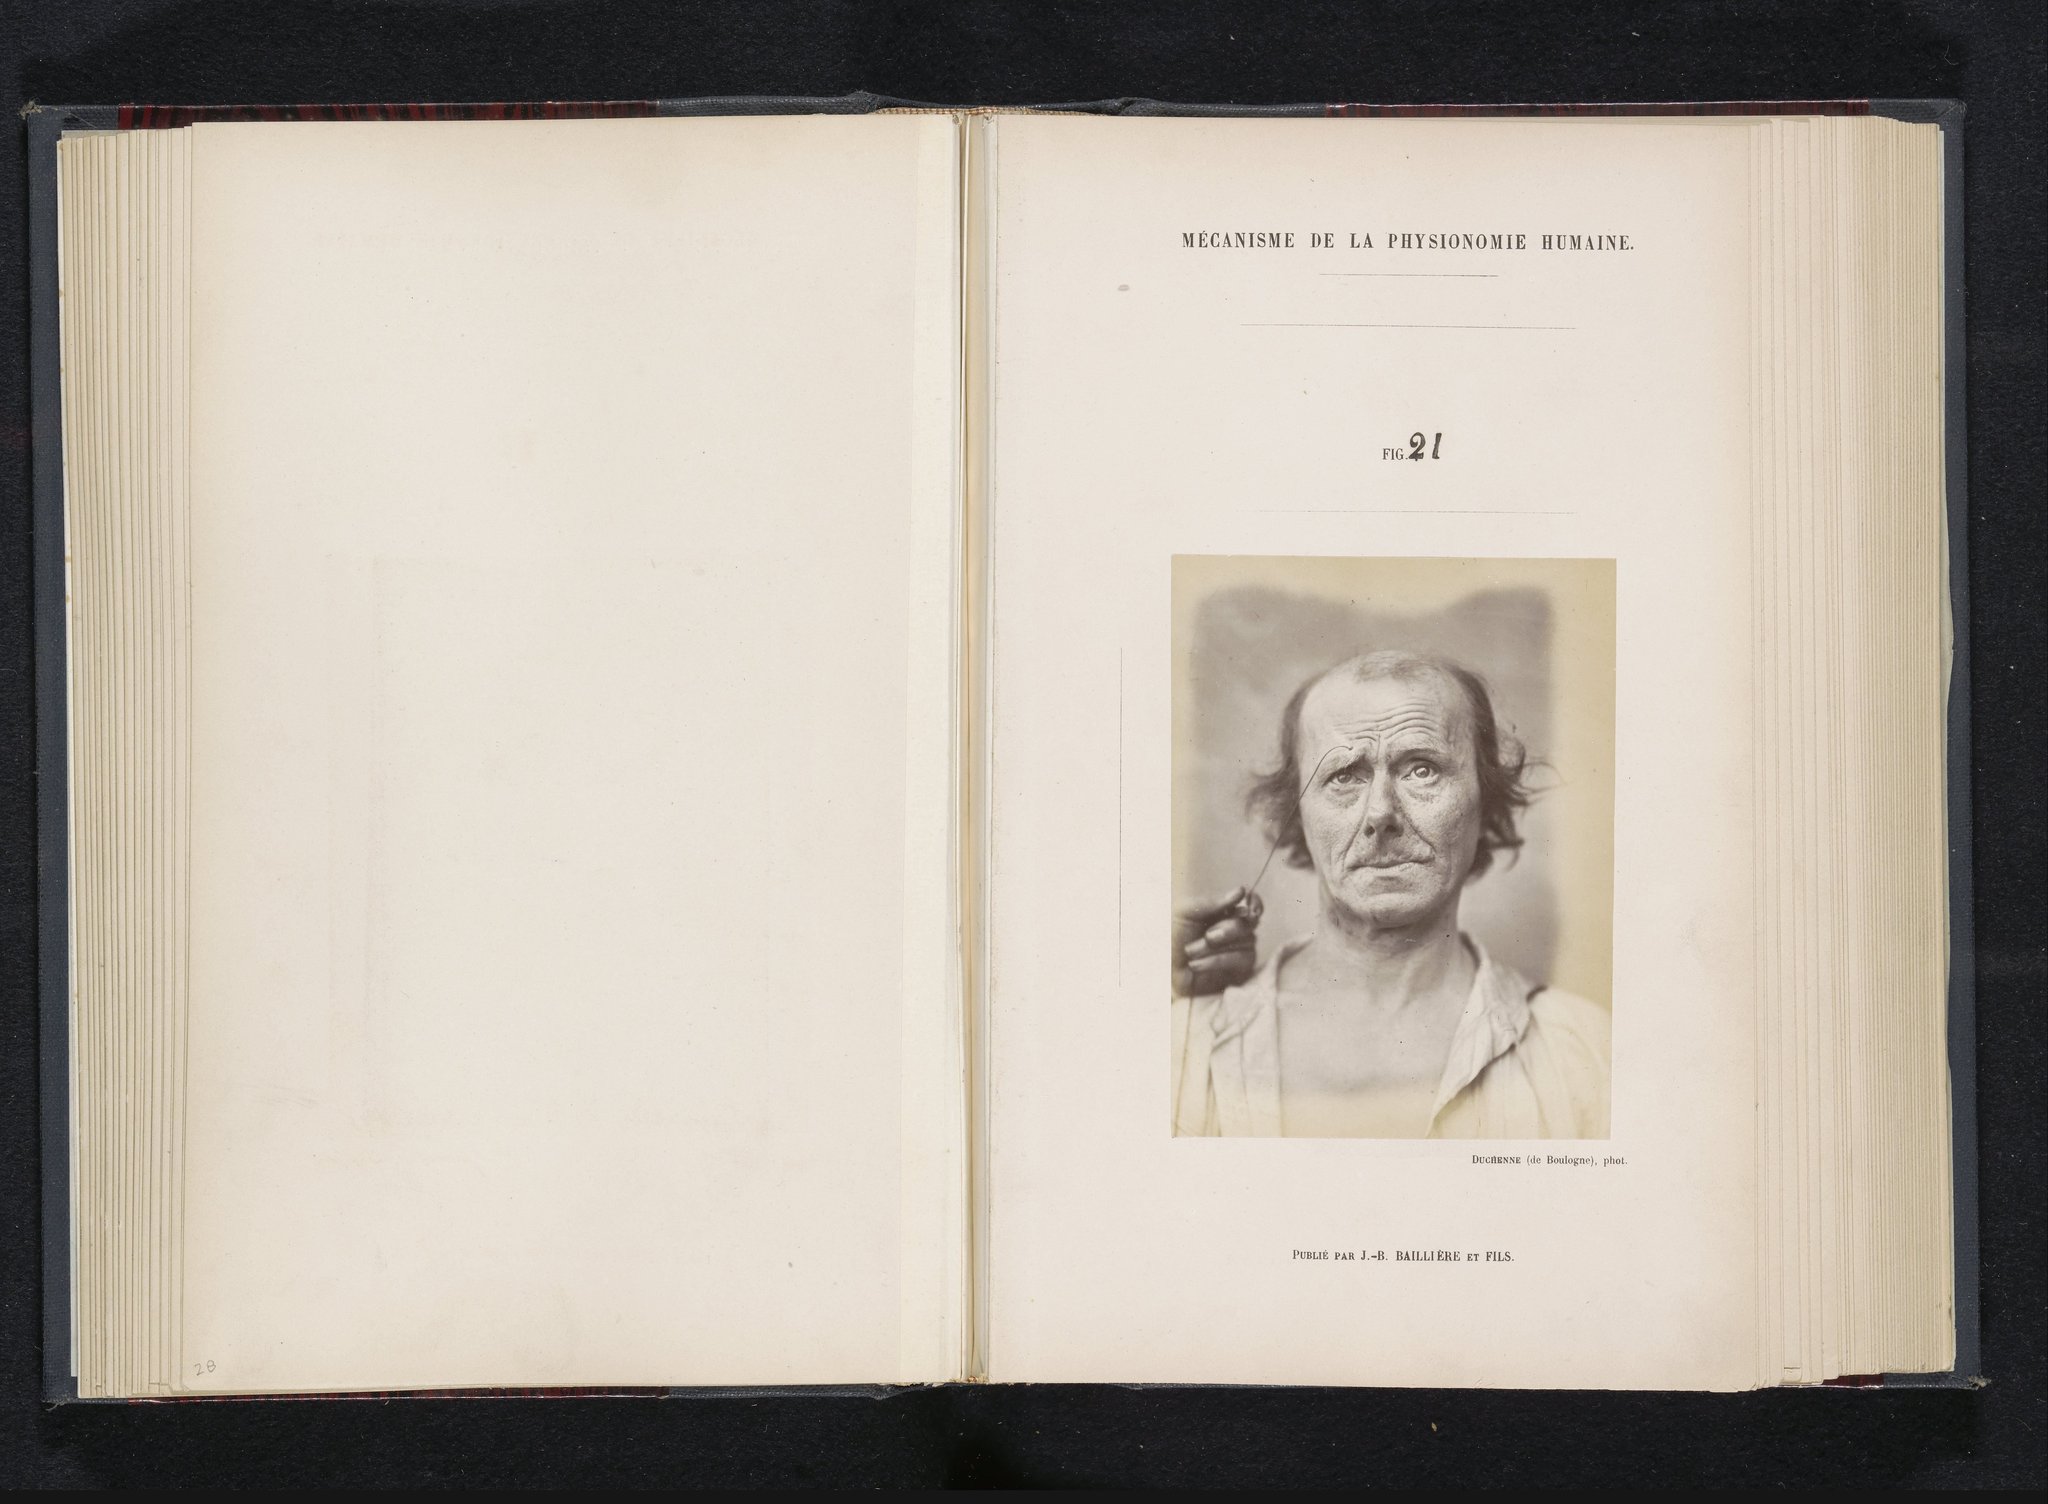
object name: photograph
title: Portret van een proefpersoon tijdens elektrostimulatie: 'un vieillard'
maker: guillaume benjamin amand duchenne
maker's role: fotograaf, medicus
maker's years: 1806-1875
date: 1860-1862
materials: paper, photographic support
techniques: albumen print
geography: france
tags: face, physiology and anatomy ~ nervous system, neurology, physiology and anatomy, old man, morphology of facial expression, physiognomy, experiment, test ~ science and technology, france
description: Ongenummerde pagina met foto 21 uit Mécanisme de la physionomie humaine ou analyse électro-physiologique de l'expression des passions (Atlas).